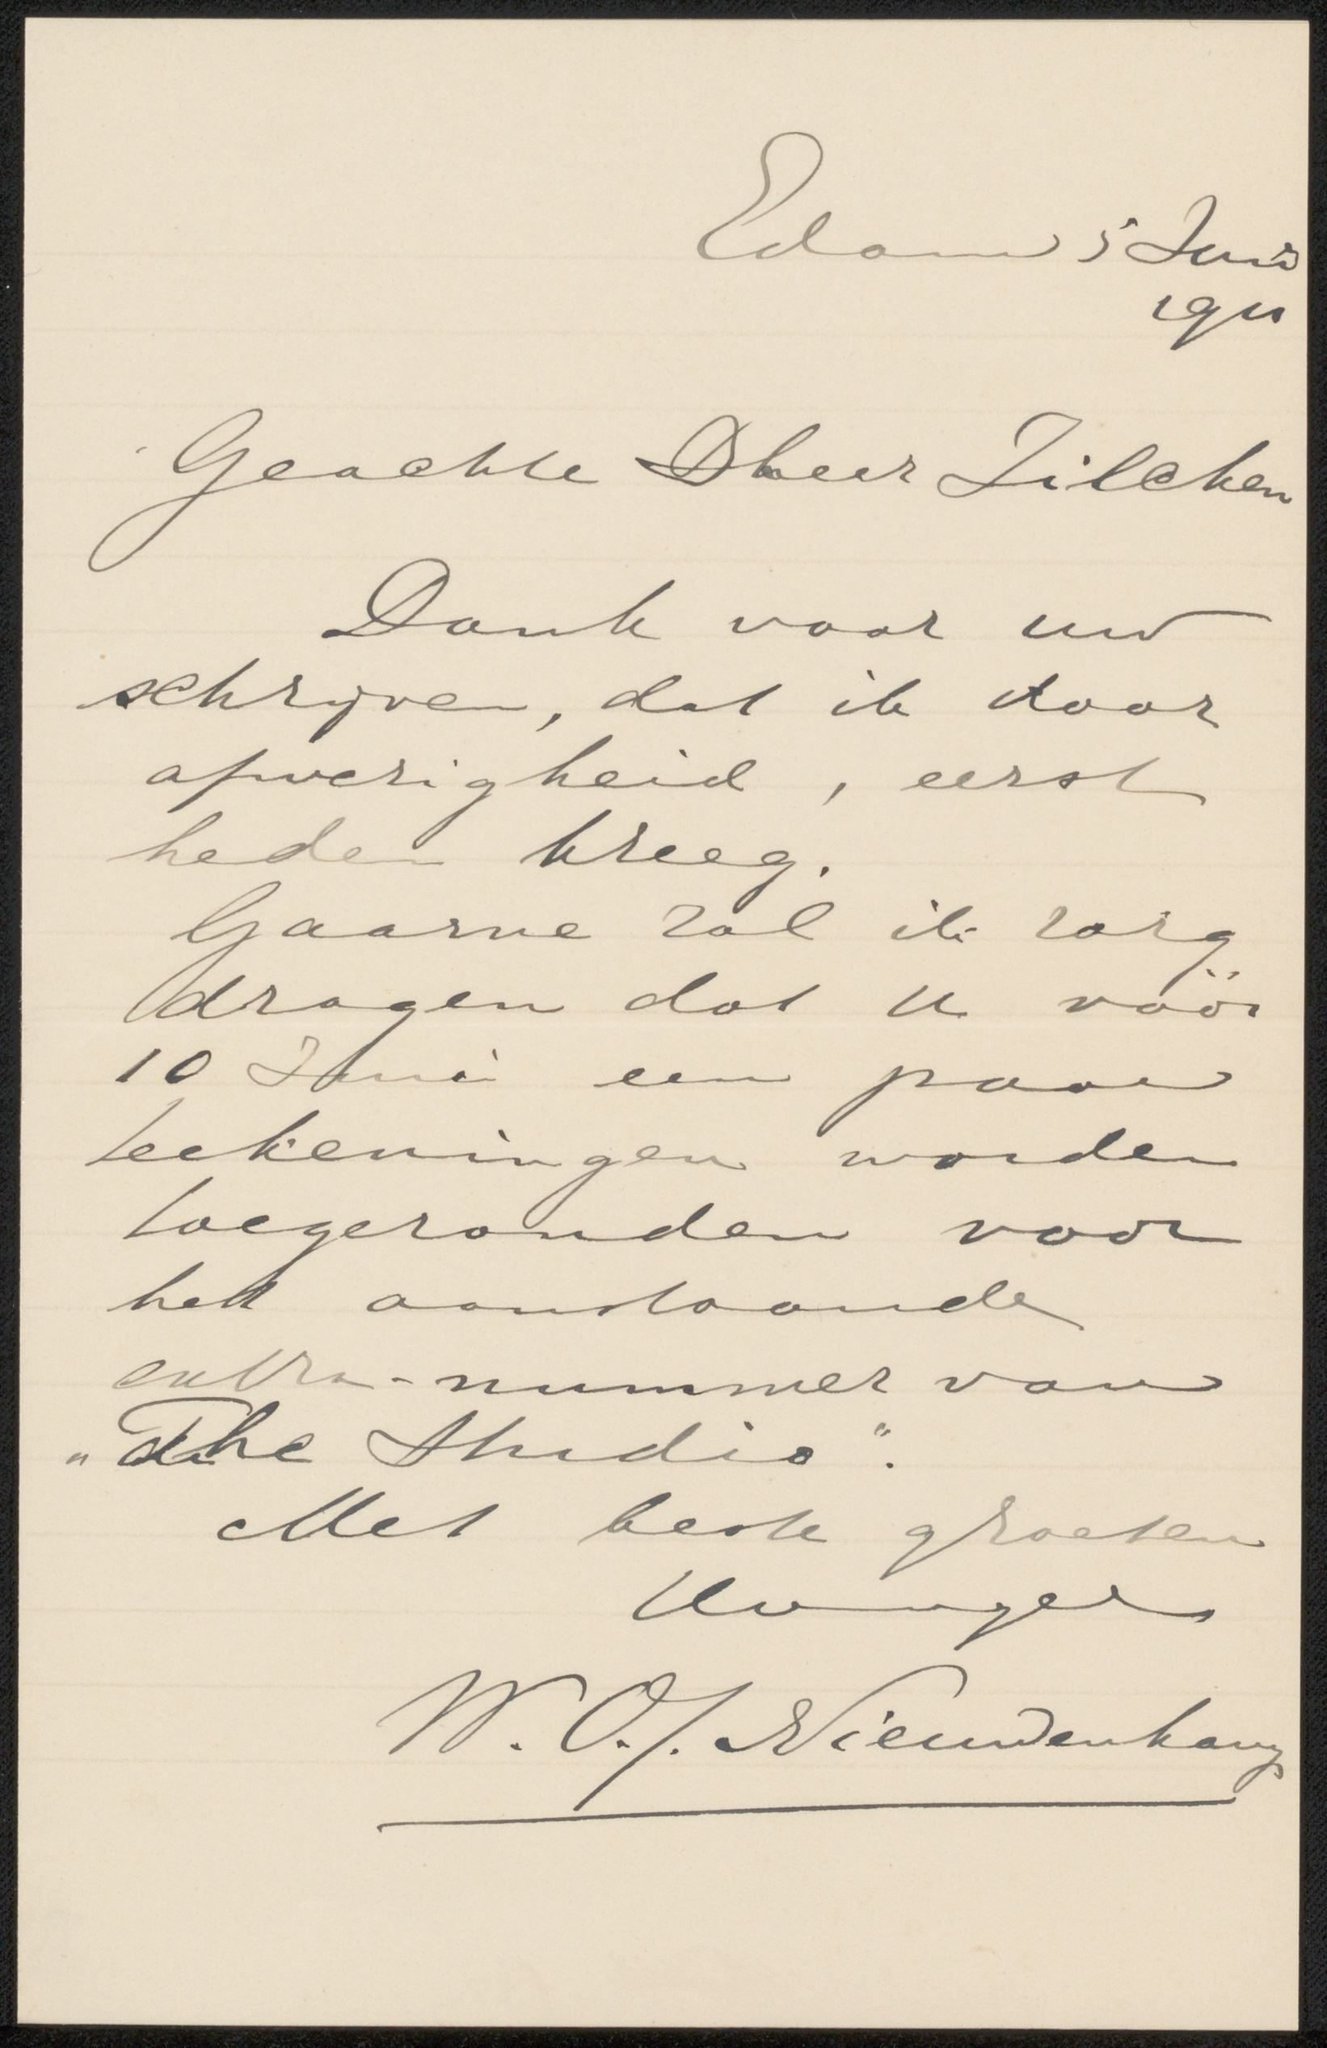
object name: letter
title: Brief aan Philip Zilcken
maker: wijnand otto jan nieuwenkamp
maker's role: draughtsman, print maker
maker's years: 1874-1950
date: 1911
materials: ink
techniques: pen, writing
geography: edam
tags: the hague, painter, philip zilcken, drawing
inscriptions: collector's mark: ‘RPK’